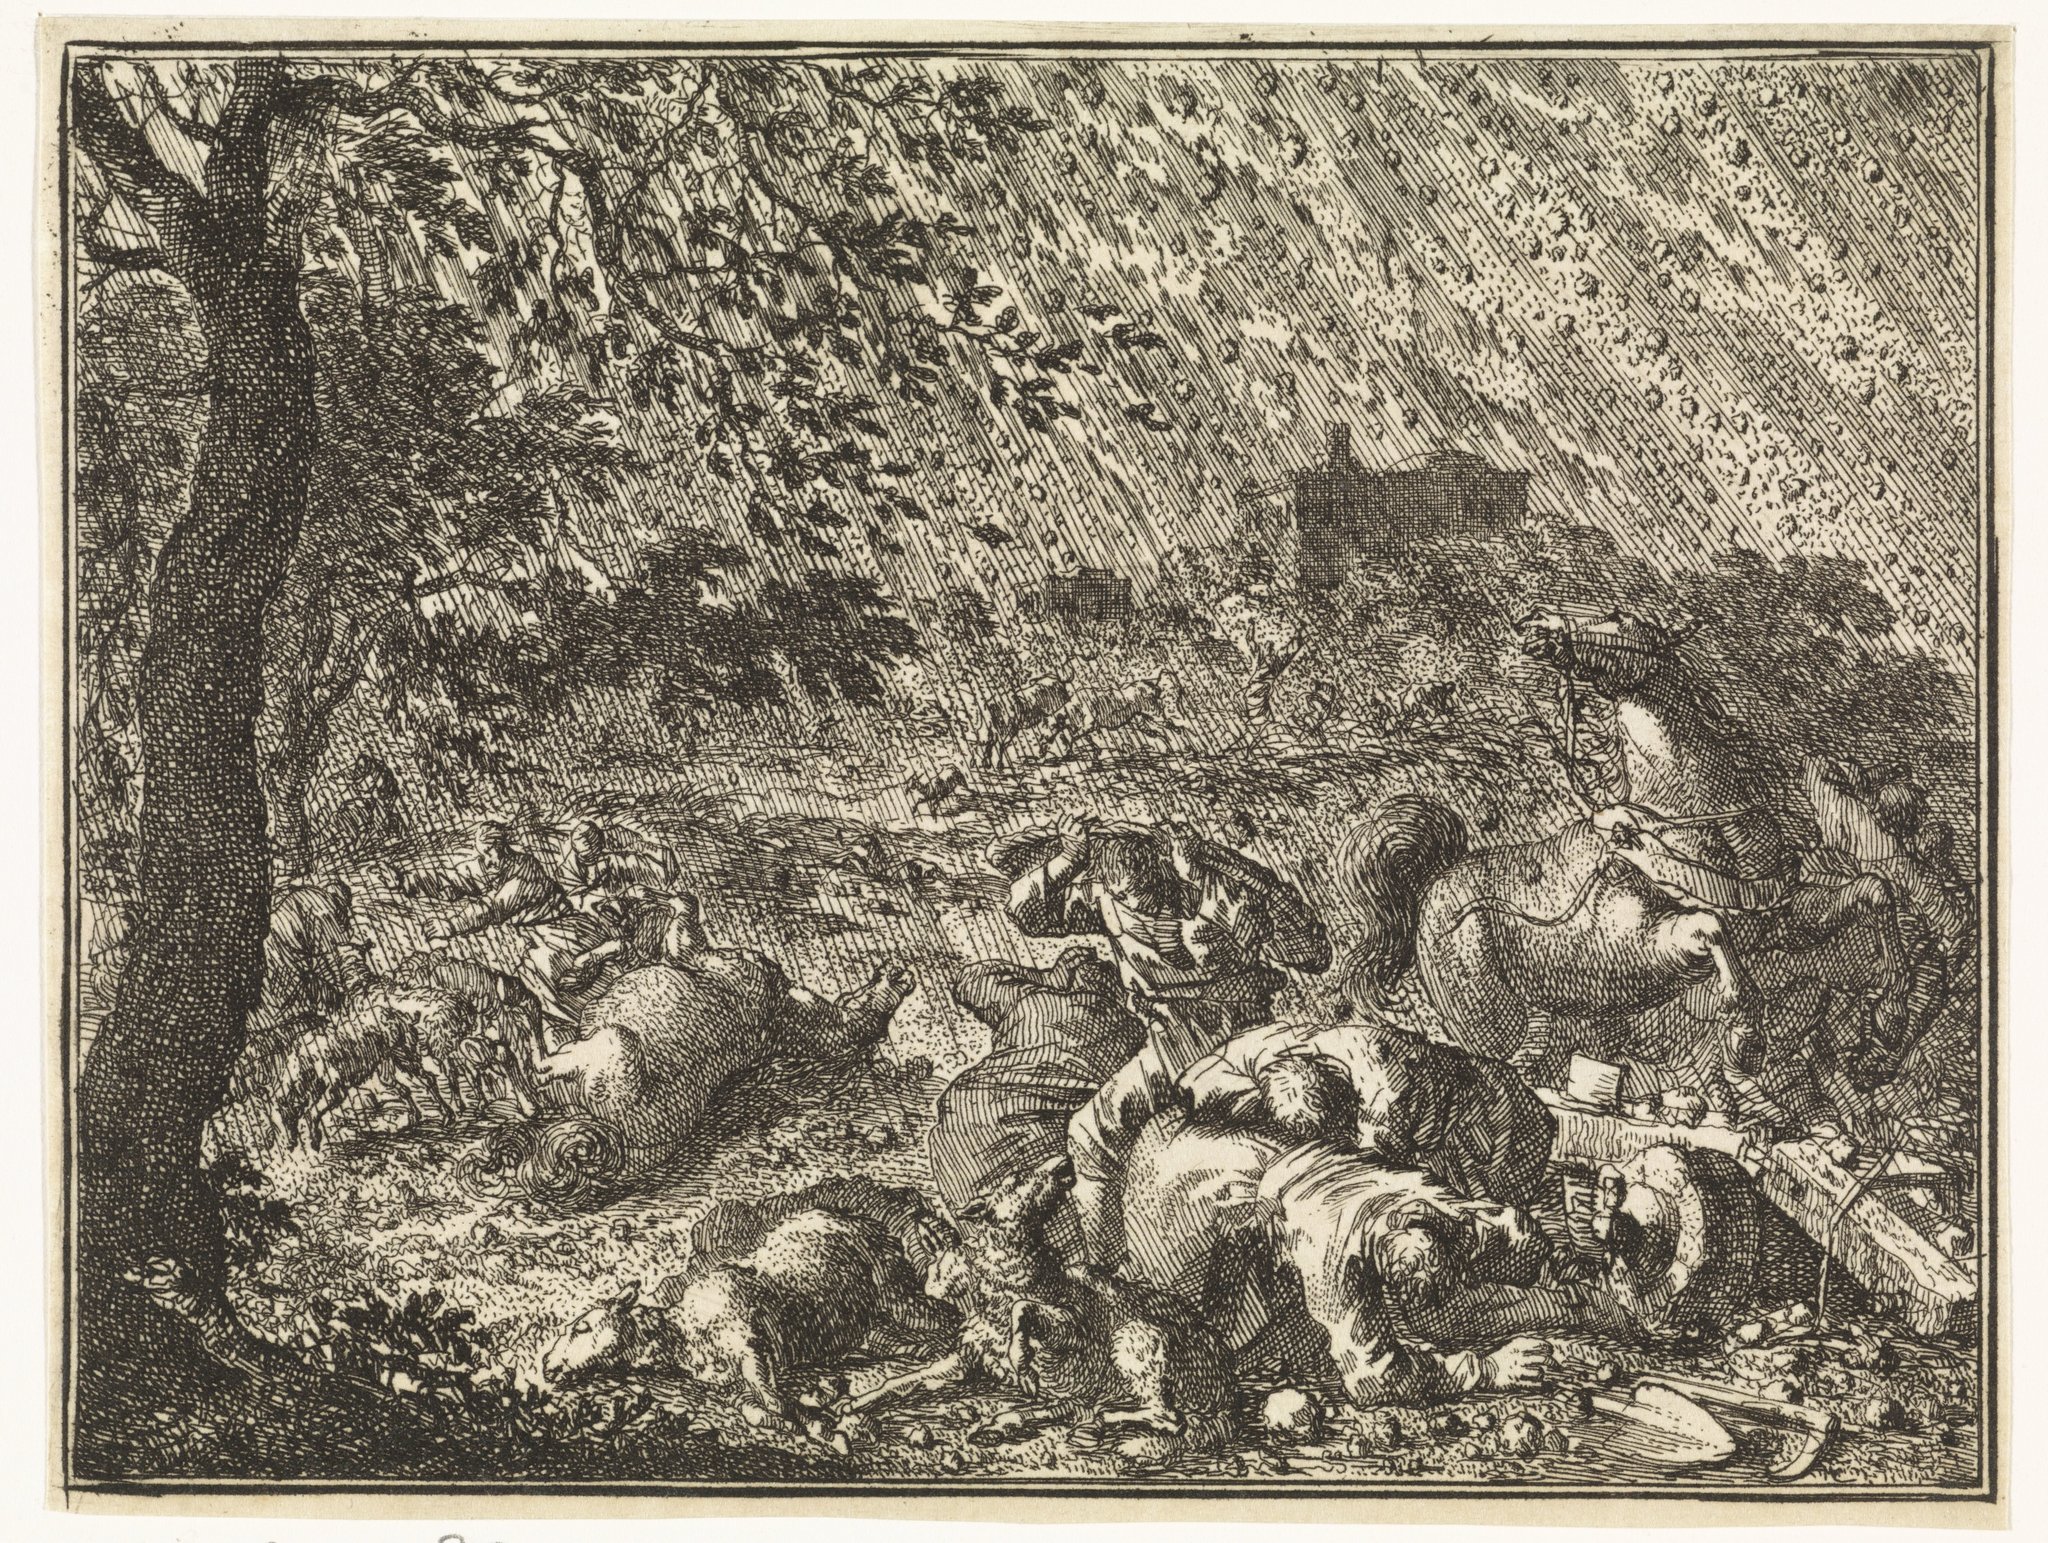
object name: print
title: Plaag van de hagel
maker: jan luyken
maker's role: draughtsman, print maker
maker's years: 1649-1712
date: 1712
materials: paper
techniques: etching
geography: amsterdam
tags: the plague of hail: moses raises his rod towards the sky, and hail and fire fall to the ground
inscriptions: collector's mark: Lugt 2228, number: ‘56’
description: Illustratie uit: Luyken, Jan. De schriftuurlyke geschiedenissen en gelykenissen van het Oude en Nieuwe Verbond, 2 delen. Amsterdam: Wed. Pieter Arentsz II en Cornelis van der Sys, 1712, dl. I.